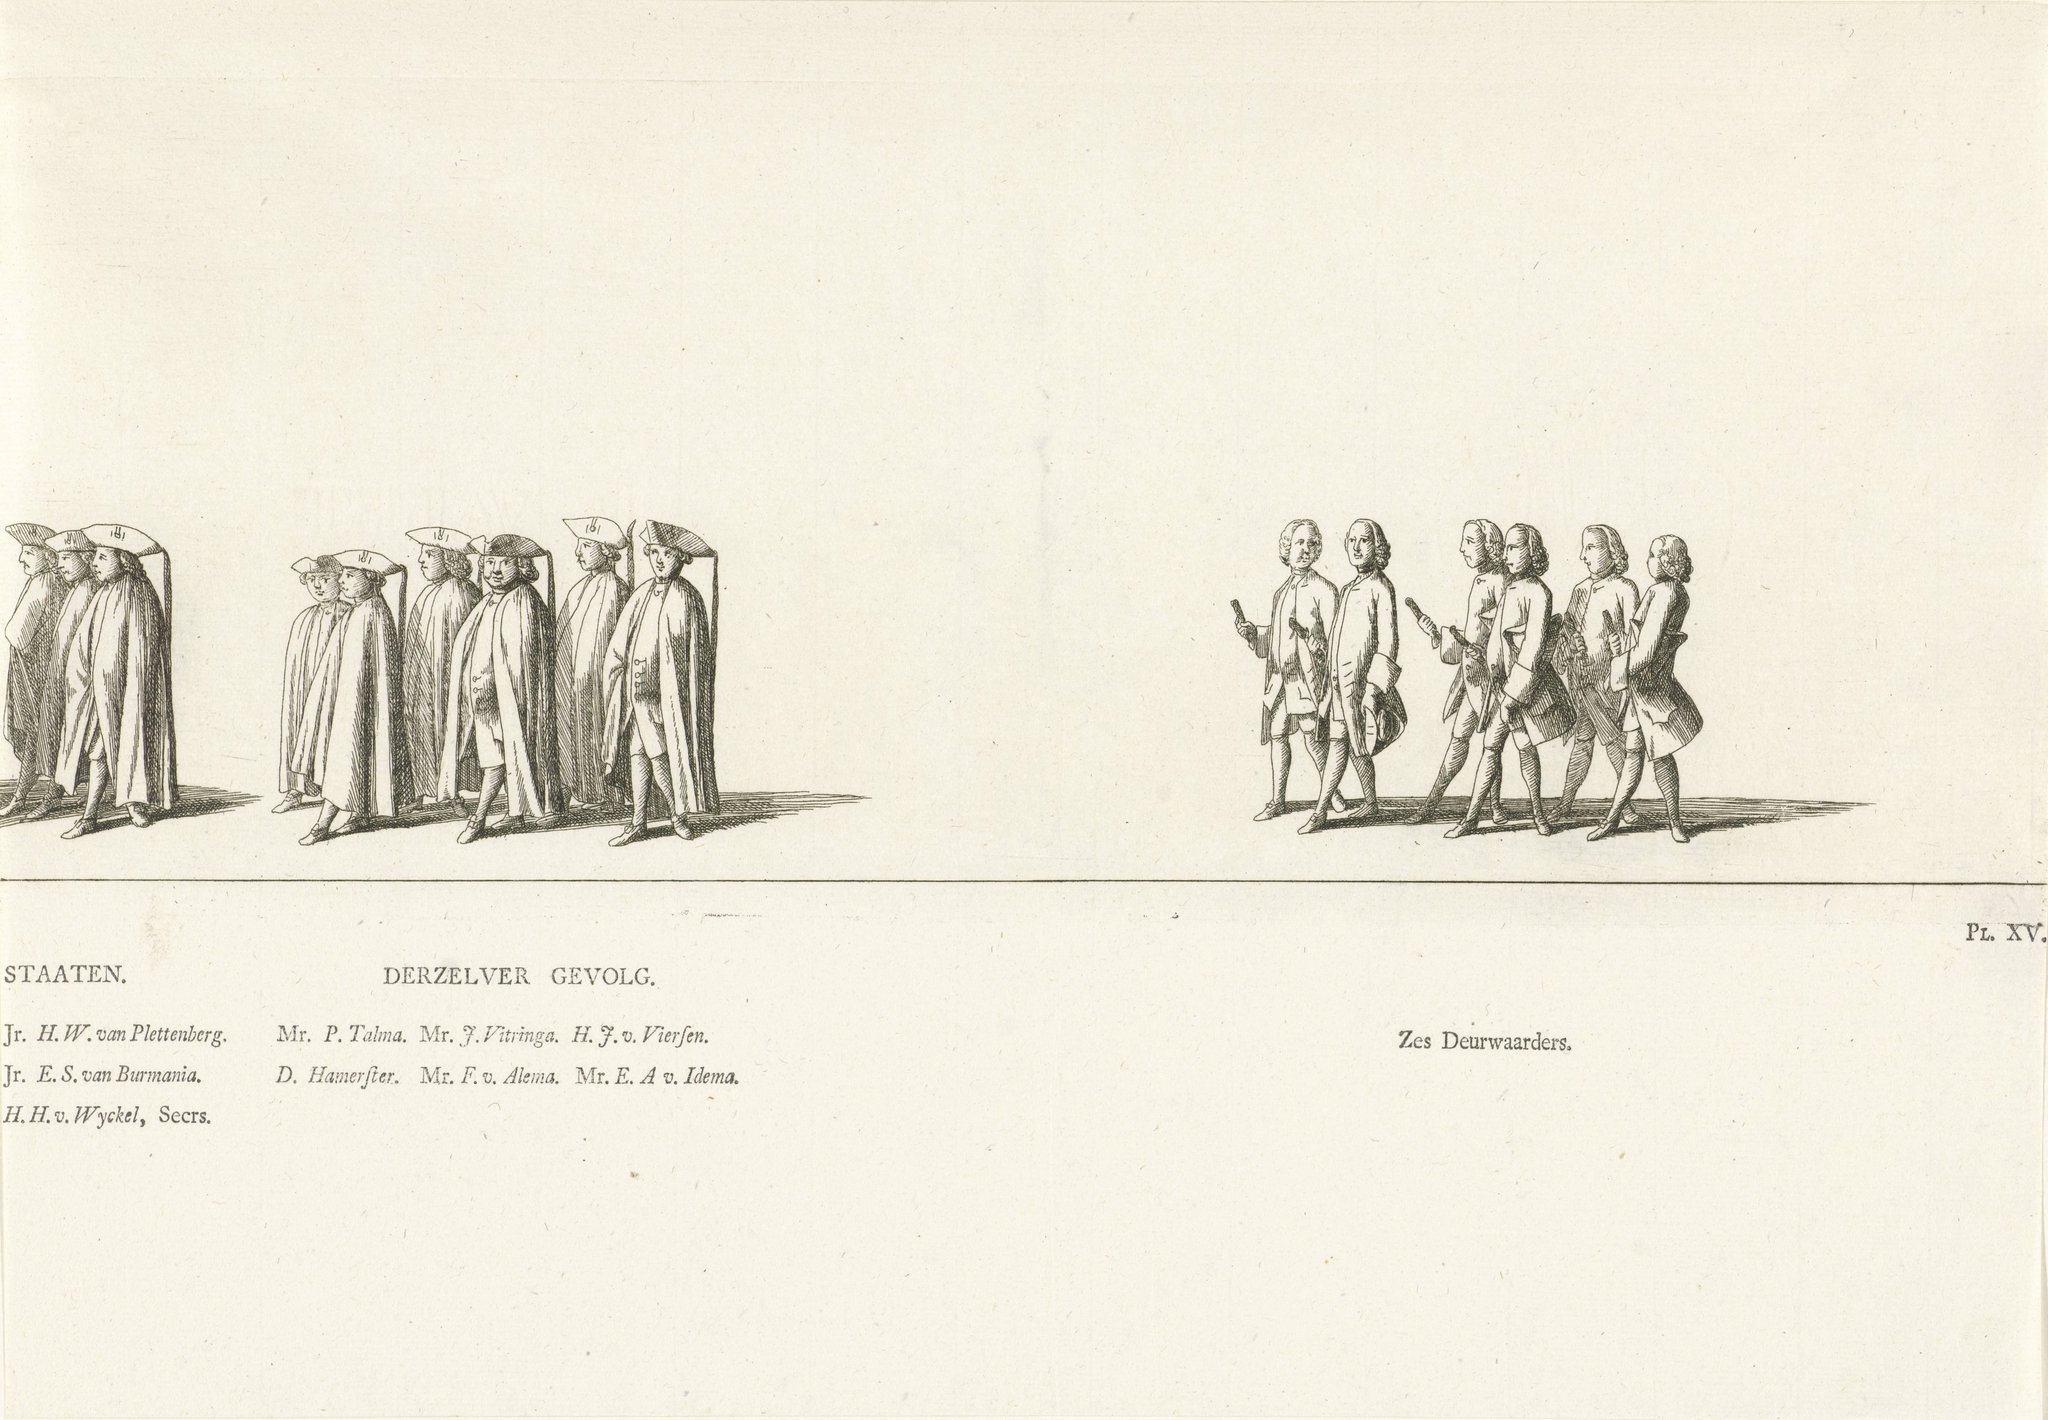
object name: print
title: Lijkstatie van prinses Maria Louise, 1765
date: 1765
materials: paper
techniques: etching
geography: leeuwarden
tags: cortege, funeral procession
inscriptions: collector's mark: Lugt 2228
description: Leden van de Gedeputeerde Staten van Friesland en deurwaarders. Gemerkt rechtsonder: Pl. XV. Op het blad onder de plaat de namen van personen in de stoet. Onderdeel van de serie platen van de begrafenis van prinses Maria Louise te Leeuwarden op 13 juni 1765.